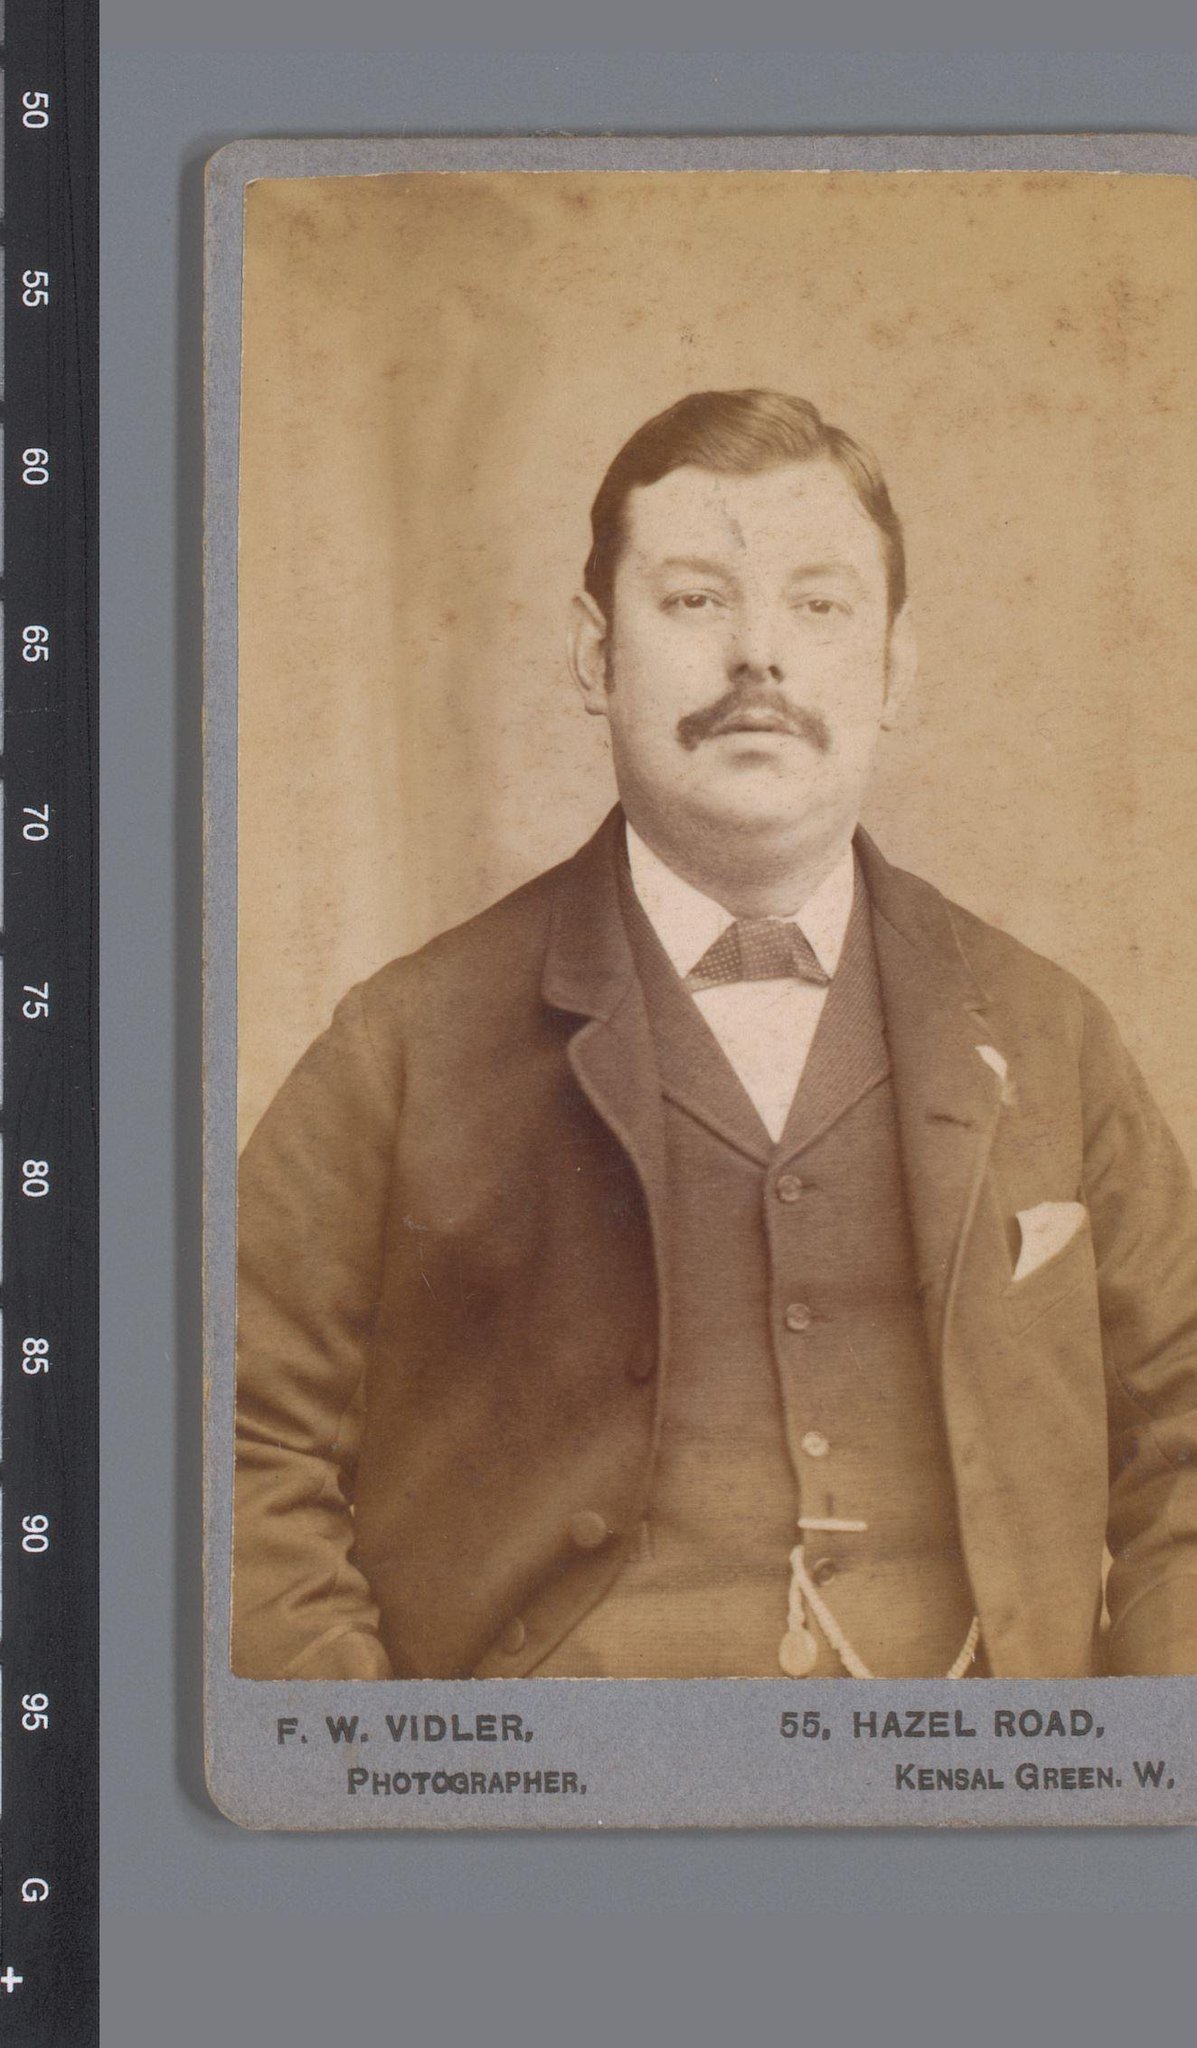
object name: photograph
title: Portret van een onbekende man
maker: frederick william wilson vidler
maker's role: fotograaf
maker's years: 1860-1929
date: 1891-1892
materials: cardboard, paper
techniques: albumen print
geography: london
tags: adult man, anonymous historical person portrayed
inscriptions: inscription: ‘All negatives kept. Further copies can be had./ This or any other Photograph enlarged to life/ size, finished in monocrome or oils, &c.’, address: ‘55, HAZEL ROAD,/ Kensal Green. W.’